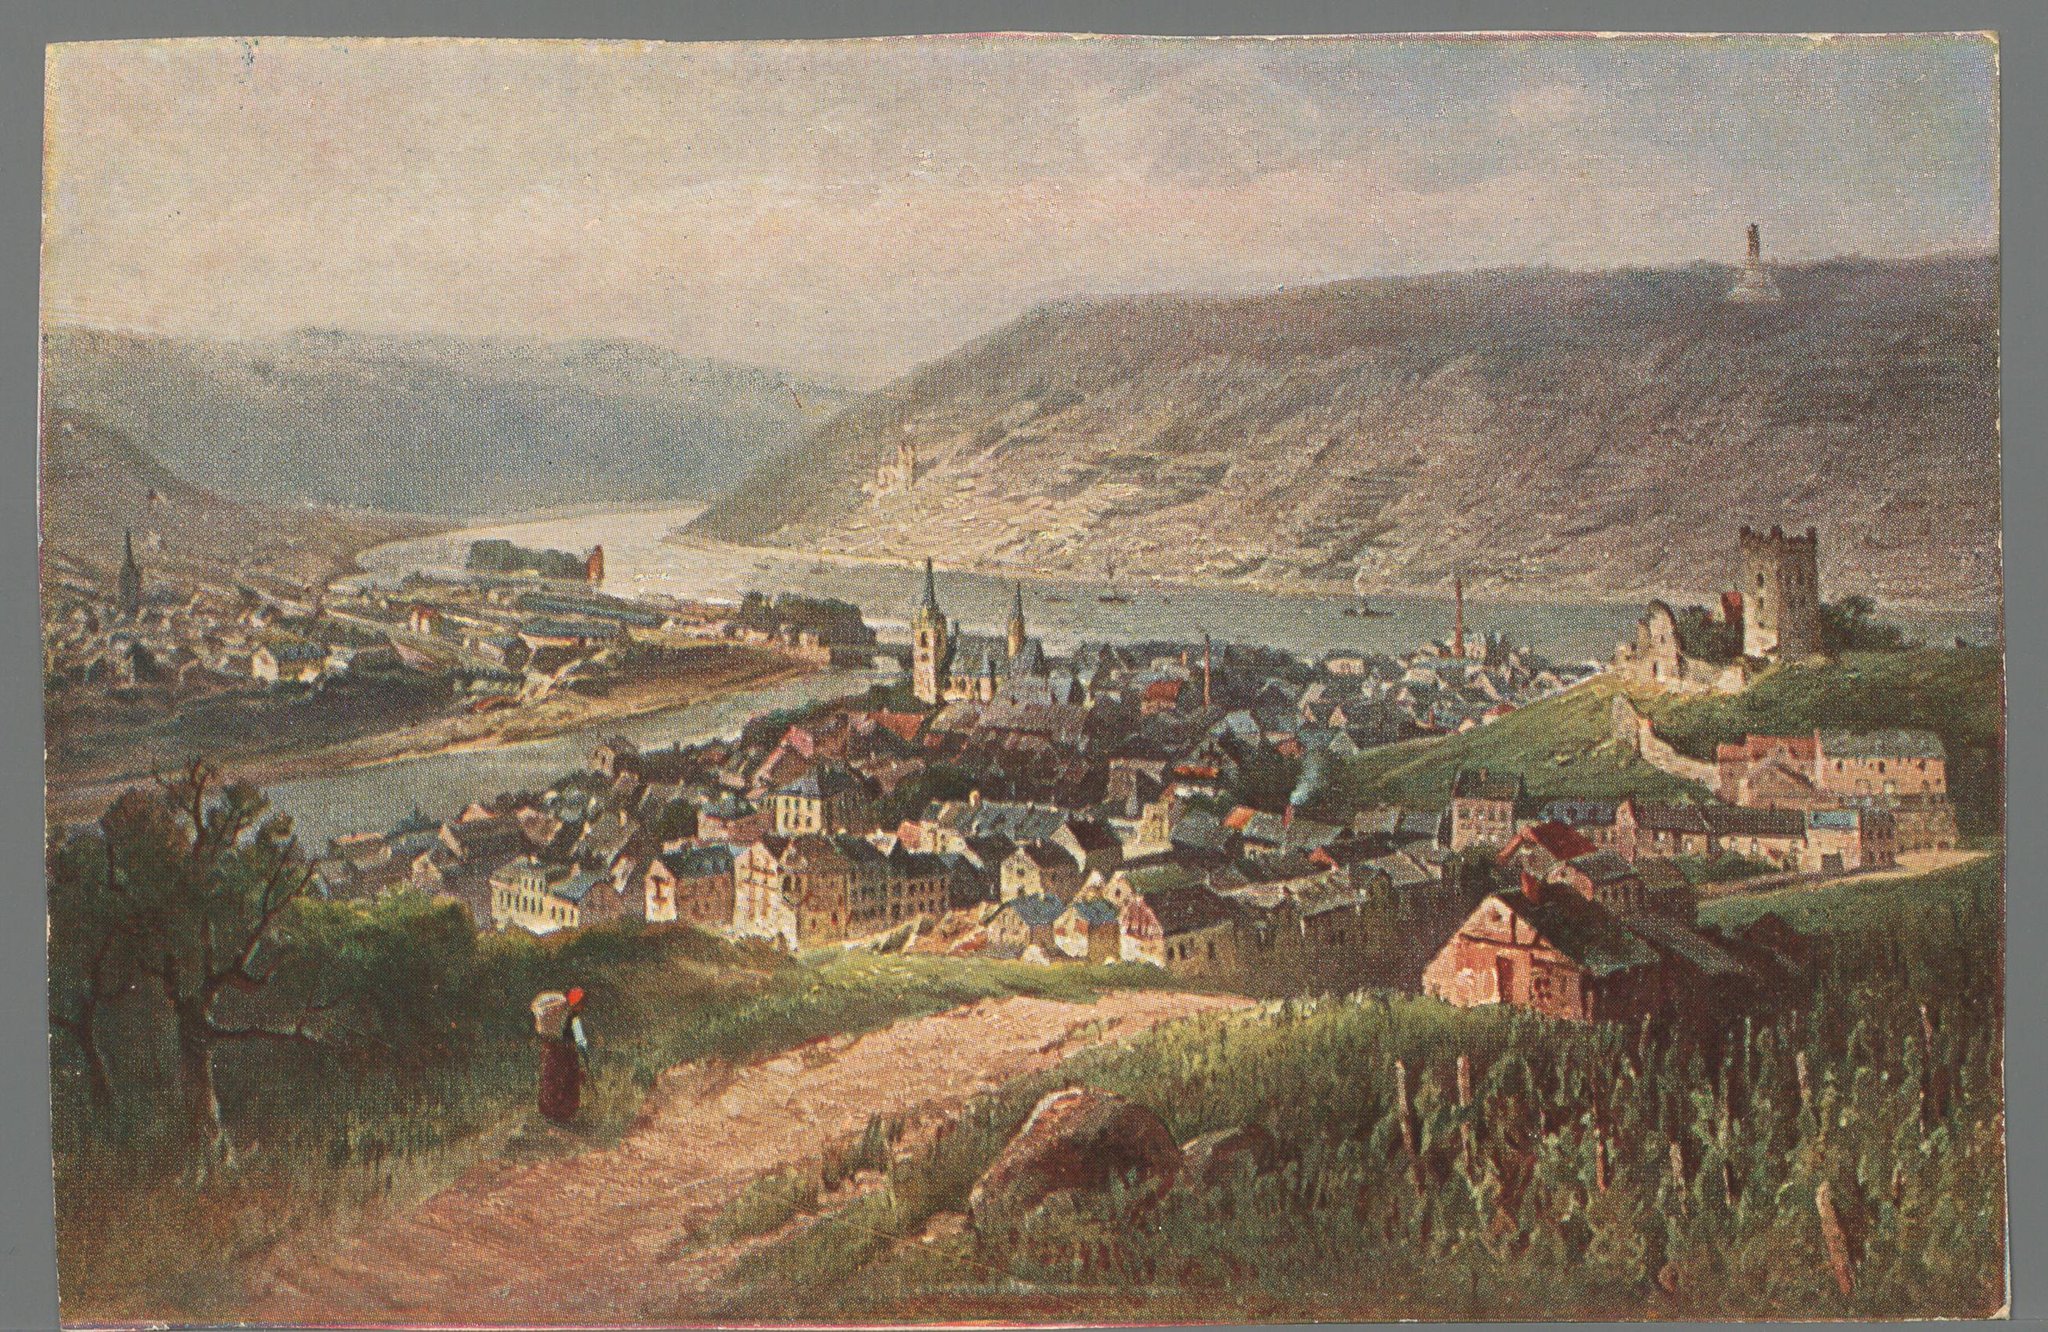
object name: ansichtkaart, prentbriefkaart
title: Bingen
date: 1905-1930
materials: cardboard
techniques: color autotype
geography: cologne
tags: city-view, and landscape with man-made constructions, river, mountains